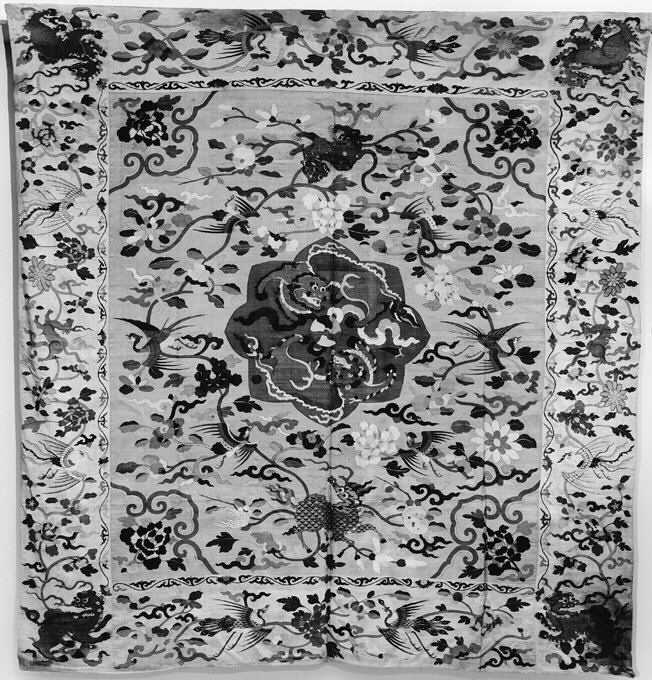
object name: furniture cover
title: Furniture Cover for Throne (?)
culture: chinese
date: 1801-1850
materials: metal thread, silk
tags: birds,mythical creatures,flowers